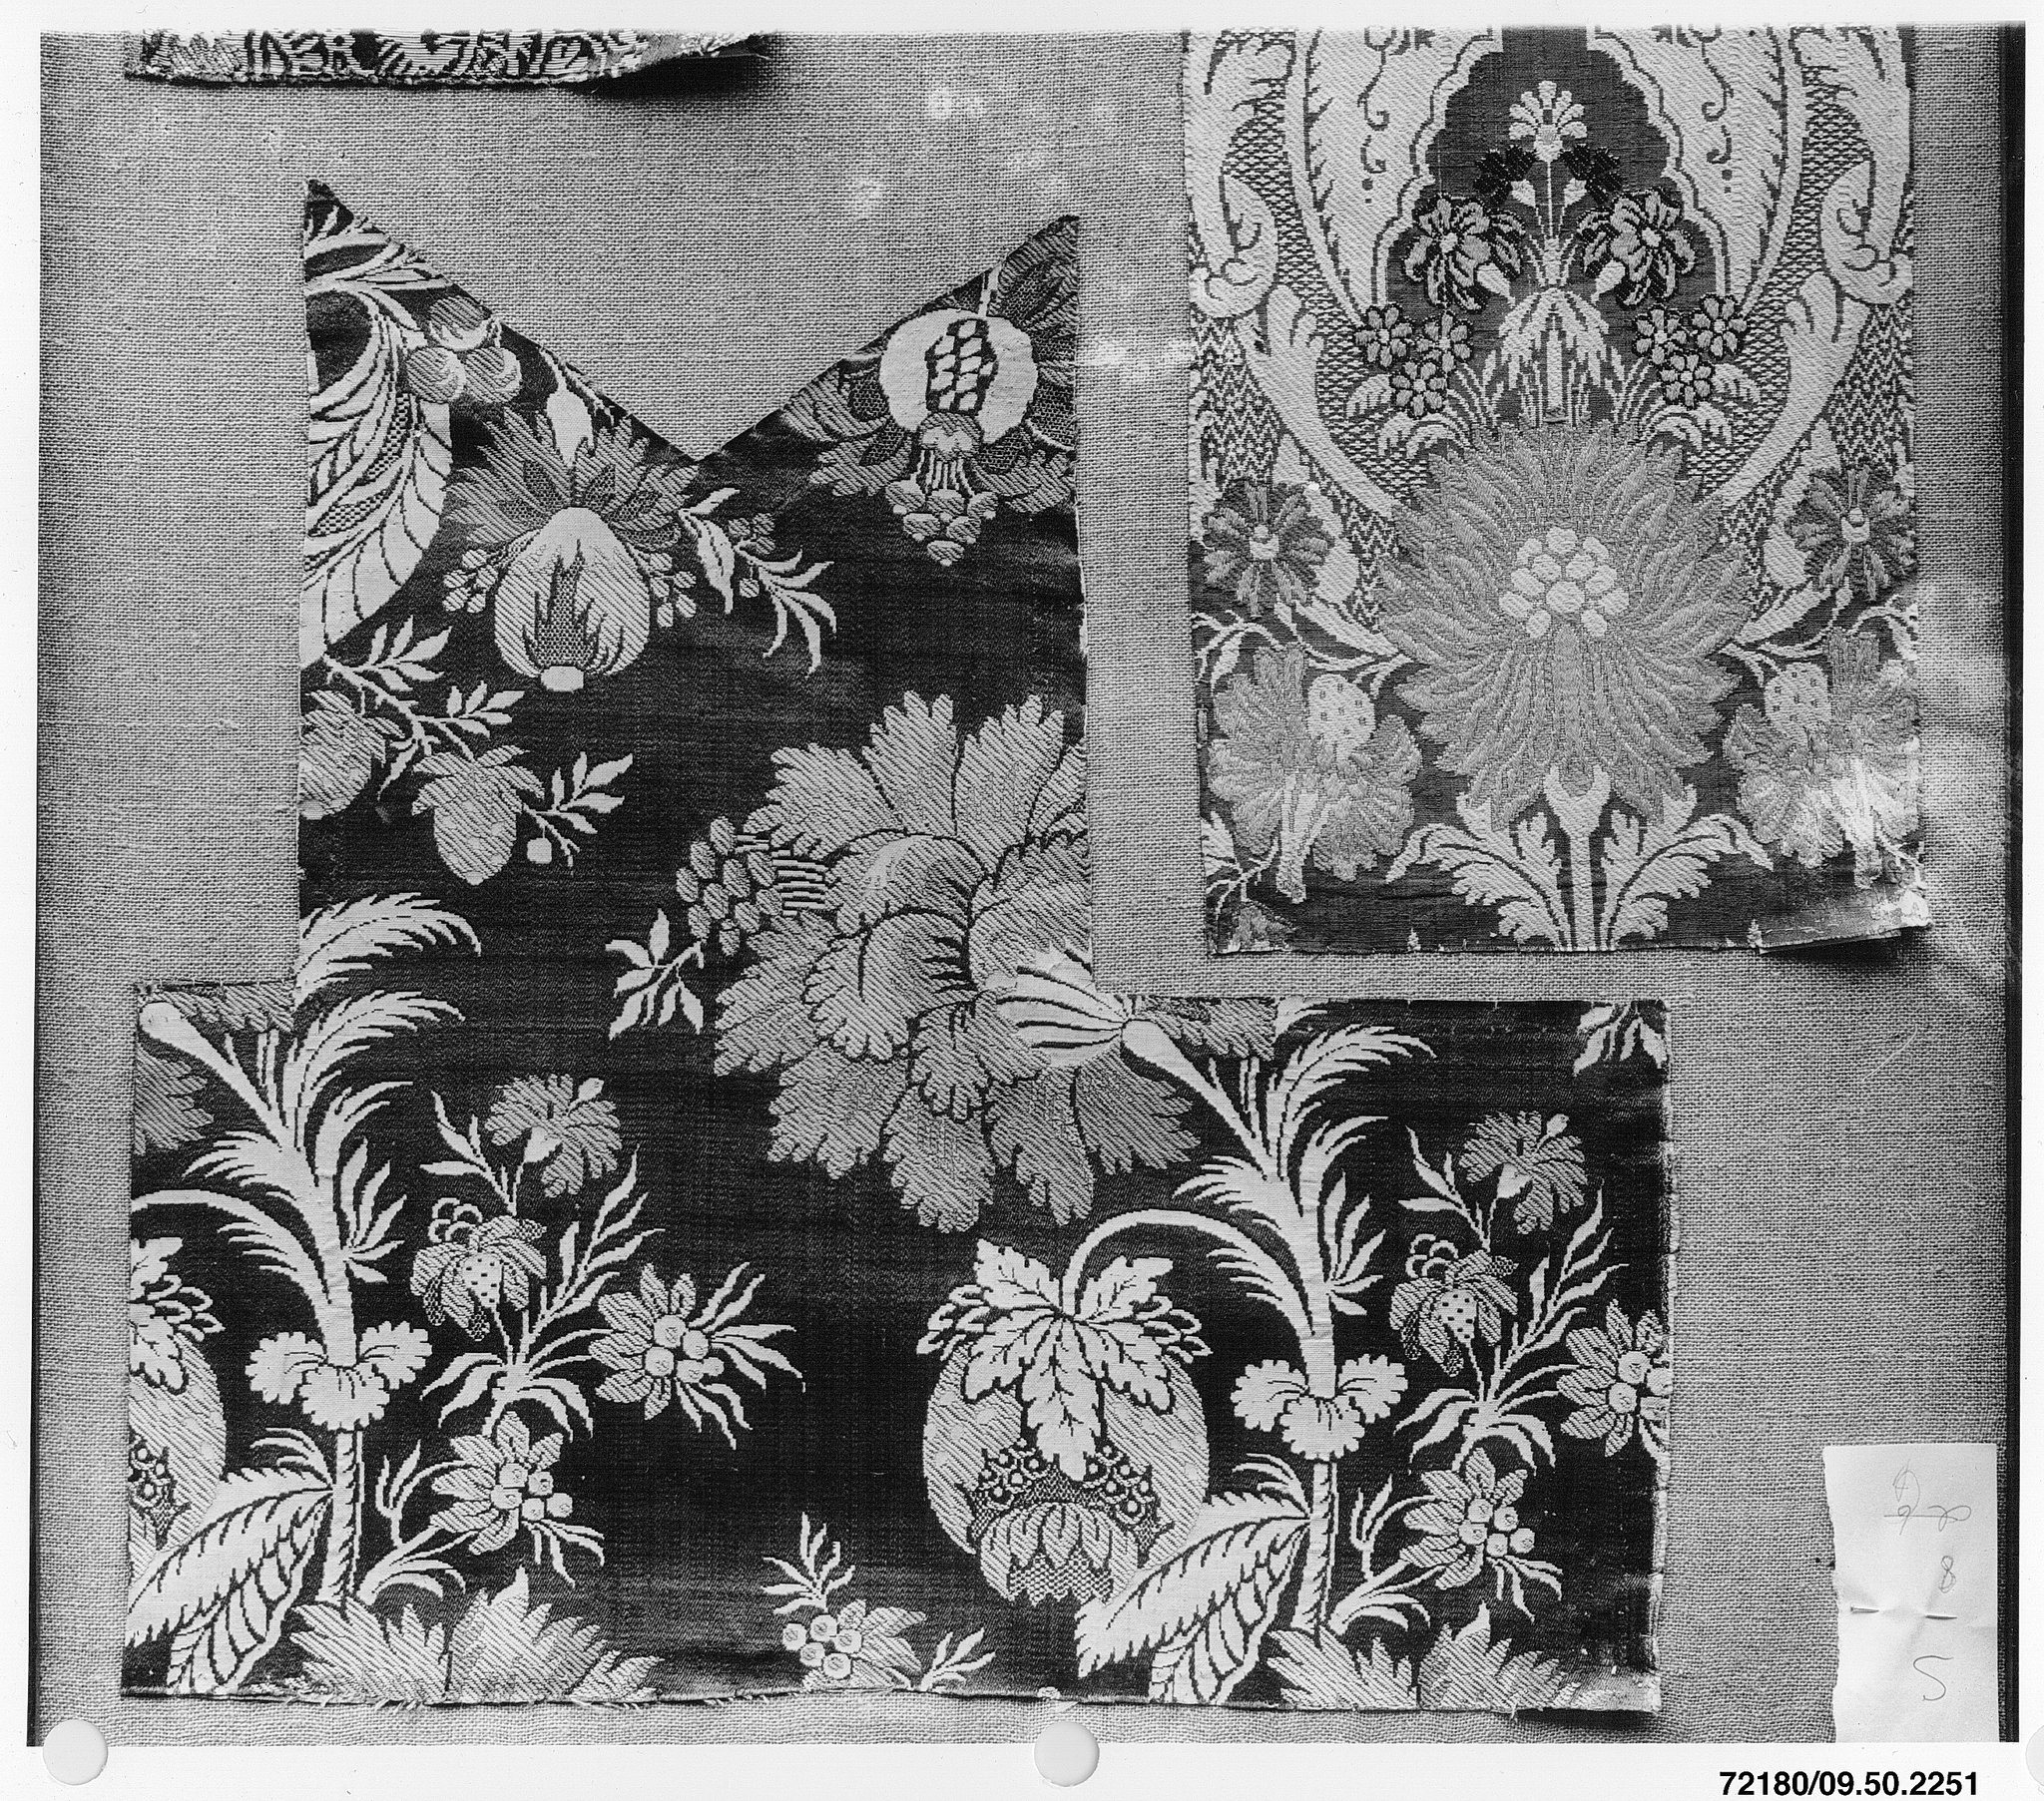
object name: piece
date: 1730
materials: silk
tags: flowers,leaves